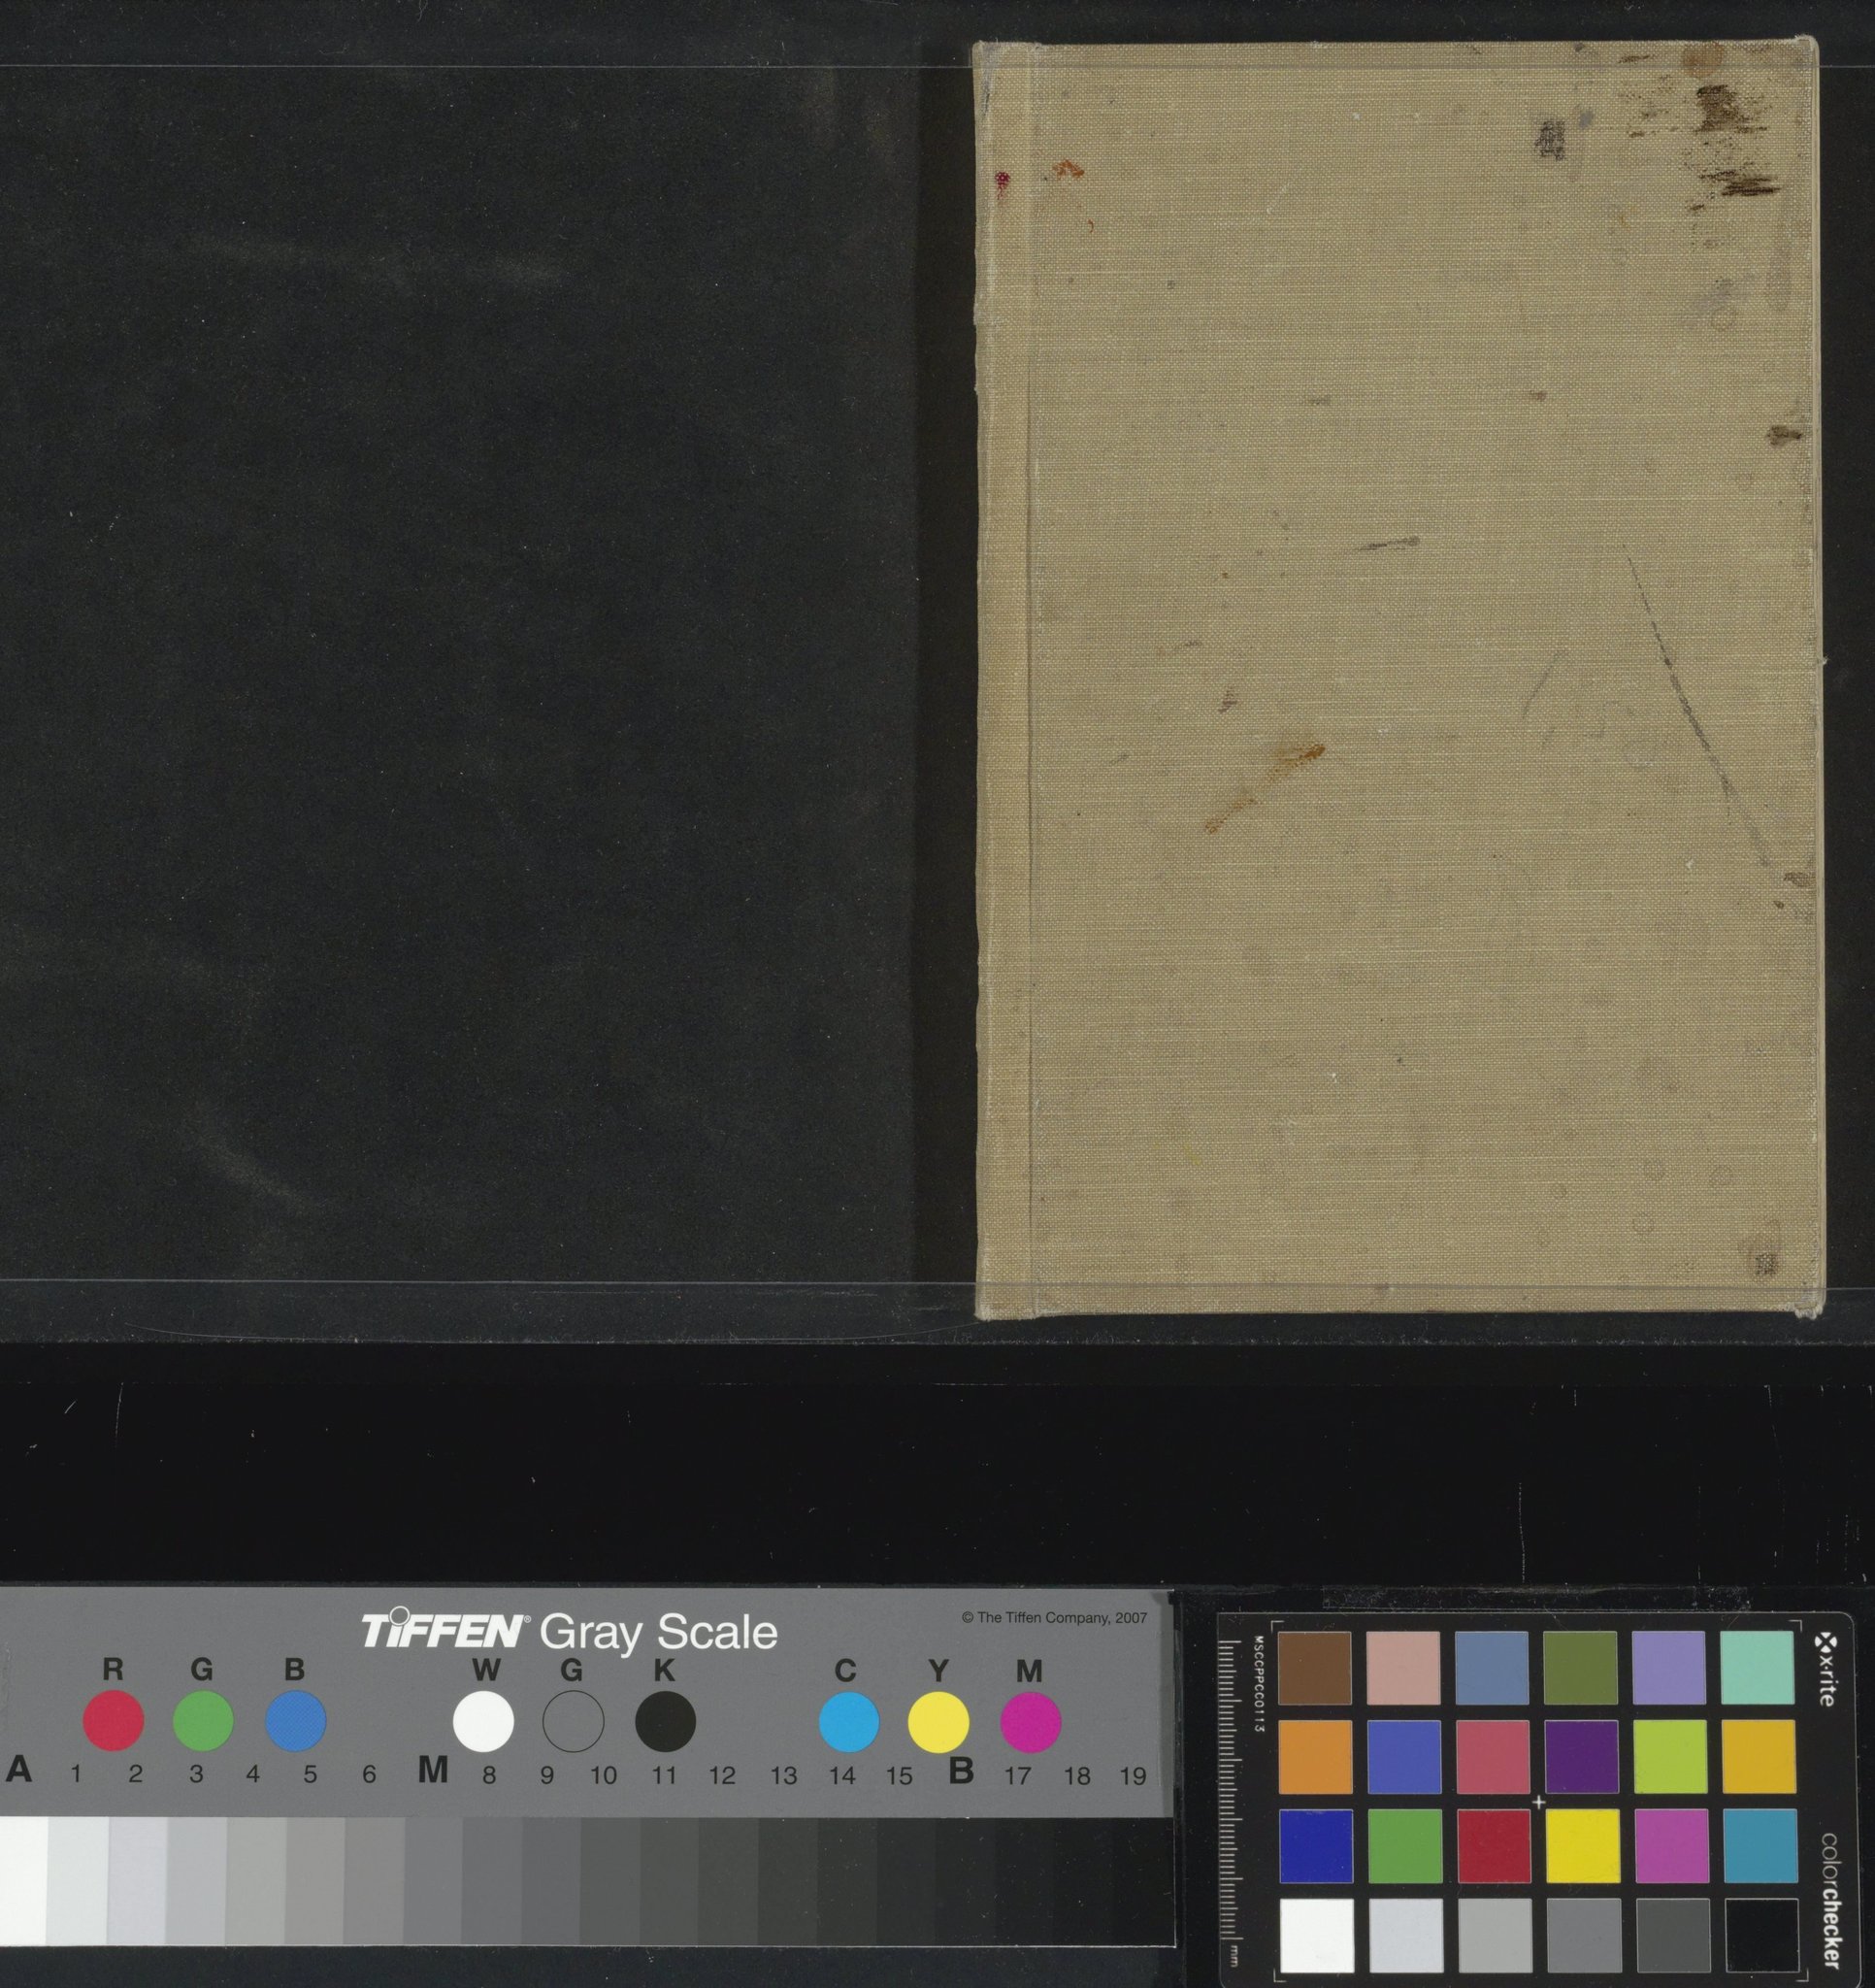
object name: sketchbook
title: Schetsboek met 74 bladen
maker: marius bauer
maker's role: draughtsman, print maker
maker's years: 1867-1932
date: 1925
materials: cardboard, chalk, ink, linen, paper, pencil, watercolor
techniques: brush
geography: indonesia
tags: asiatic races and peoples, dancing, ritual practices ~ hinduism, buddhism, jainism, folk costume, regional costume, street (+ city(-scape) with figures, staffage), indonesia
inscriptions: collector's mark: Lugt 2228, retailer's mark: ‘SKETCHER'S/ NOTE BOOK./ Series A 42./ containing 80 leaves of good white paper/ MANUFACTURED BY/ GEO. ROWNEY & Co.,/ LONDON, W., ENGLAND/ SIZE No. 2 - 8 1/2 x 5 1/2 inches./ Dimensions de l'album 21 x 14 cm.’, retailer's mark: ‘SCHOUTEN & VOSKUIL/ Leidschestraat 75./ AMSTERDAM’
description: Schetsboek bestaande uit 74 bladen met schetsen gemaakt tijdens een reis in Nederlands-Indië, met voornamelijk figuurstudies van Indonesiërs in traditioneel kostuum, dansers en (dans)voorstellingen, straatscènes, optochten, de viering van een offerfeest en rouwstoeten voor een crematie.